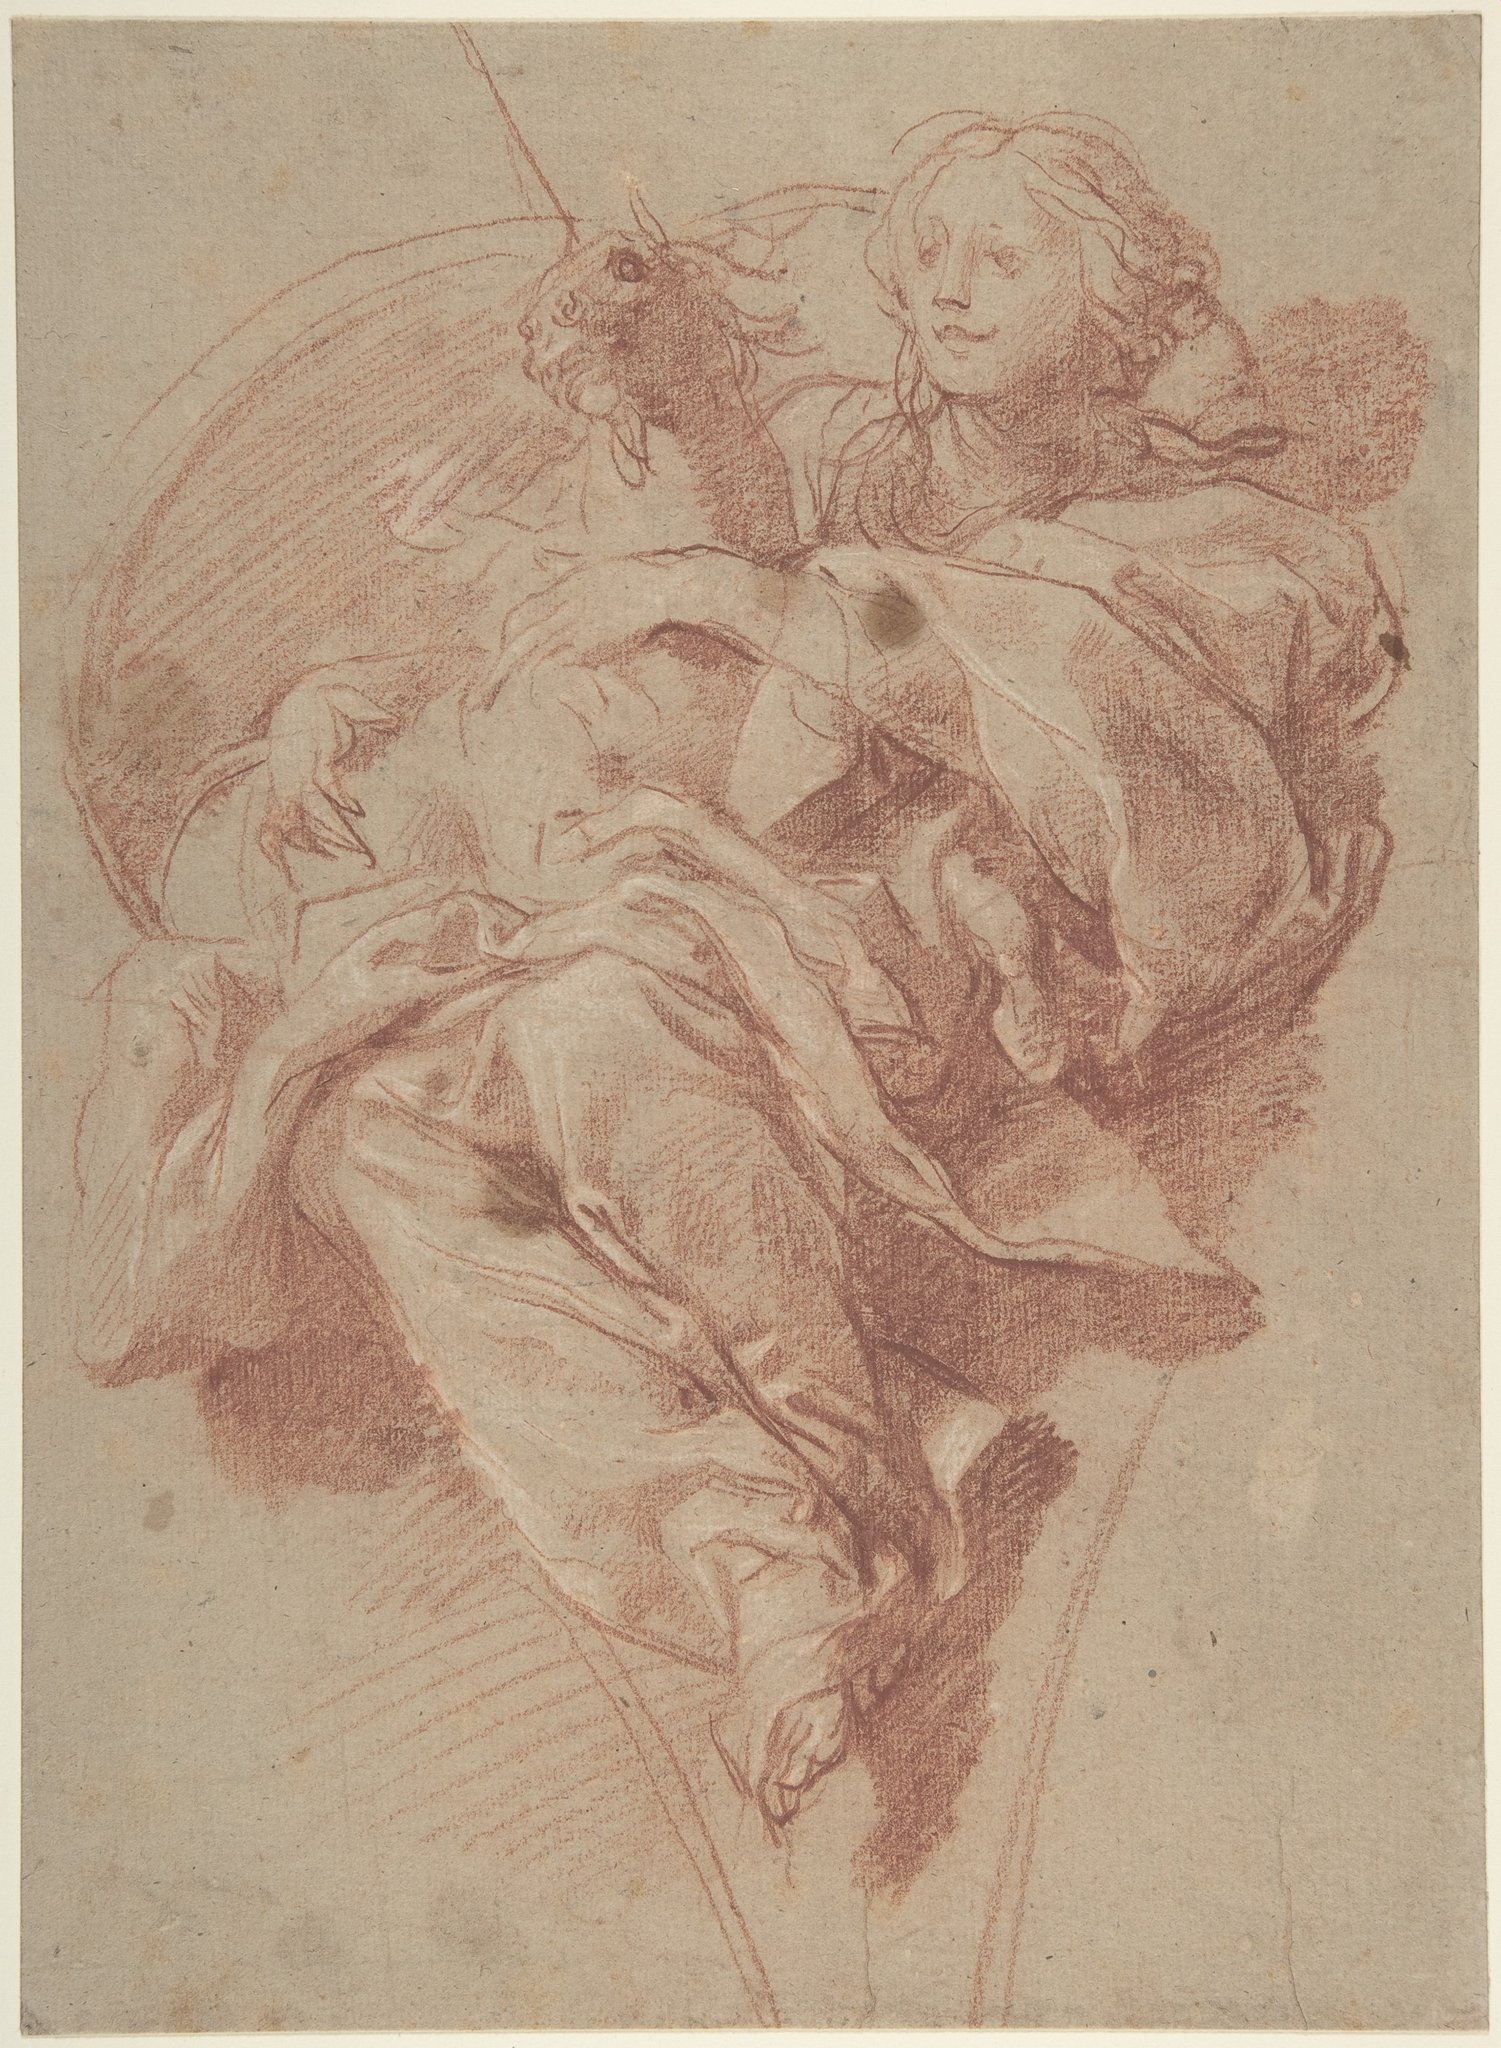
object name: drawing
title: Allegorical Figure of Purity with a Unicorn (recto); Study for Drapery (verso)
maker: baldassarre franceschini (il volterrano)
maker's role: artist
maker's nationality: italian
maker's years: 1611-1690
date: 1650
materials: chalk, paper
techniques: highlighting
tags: women,unicorns